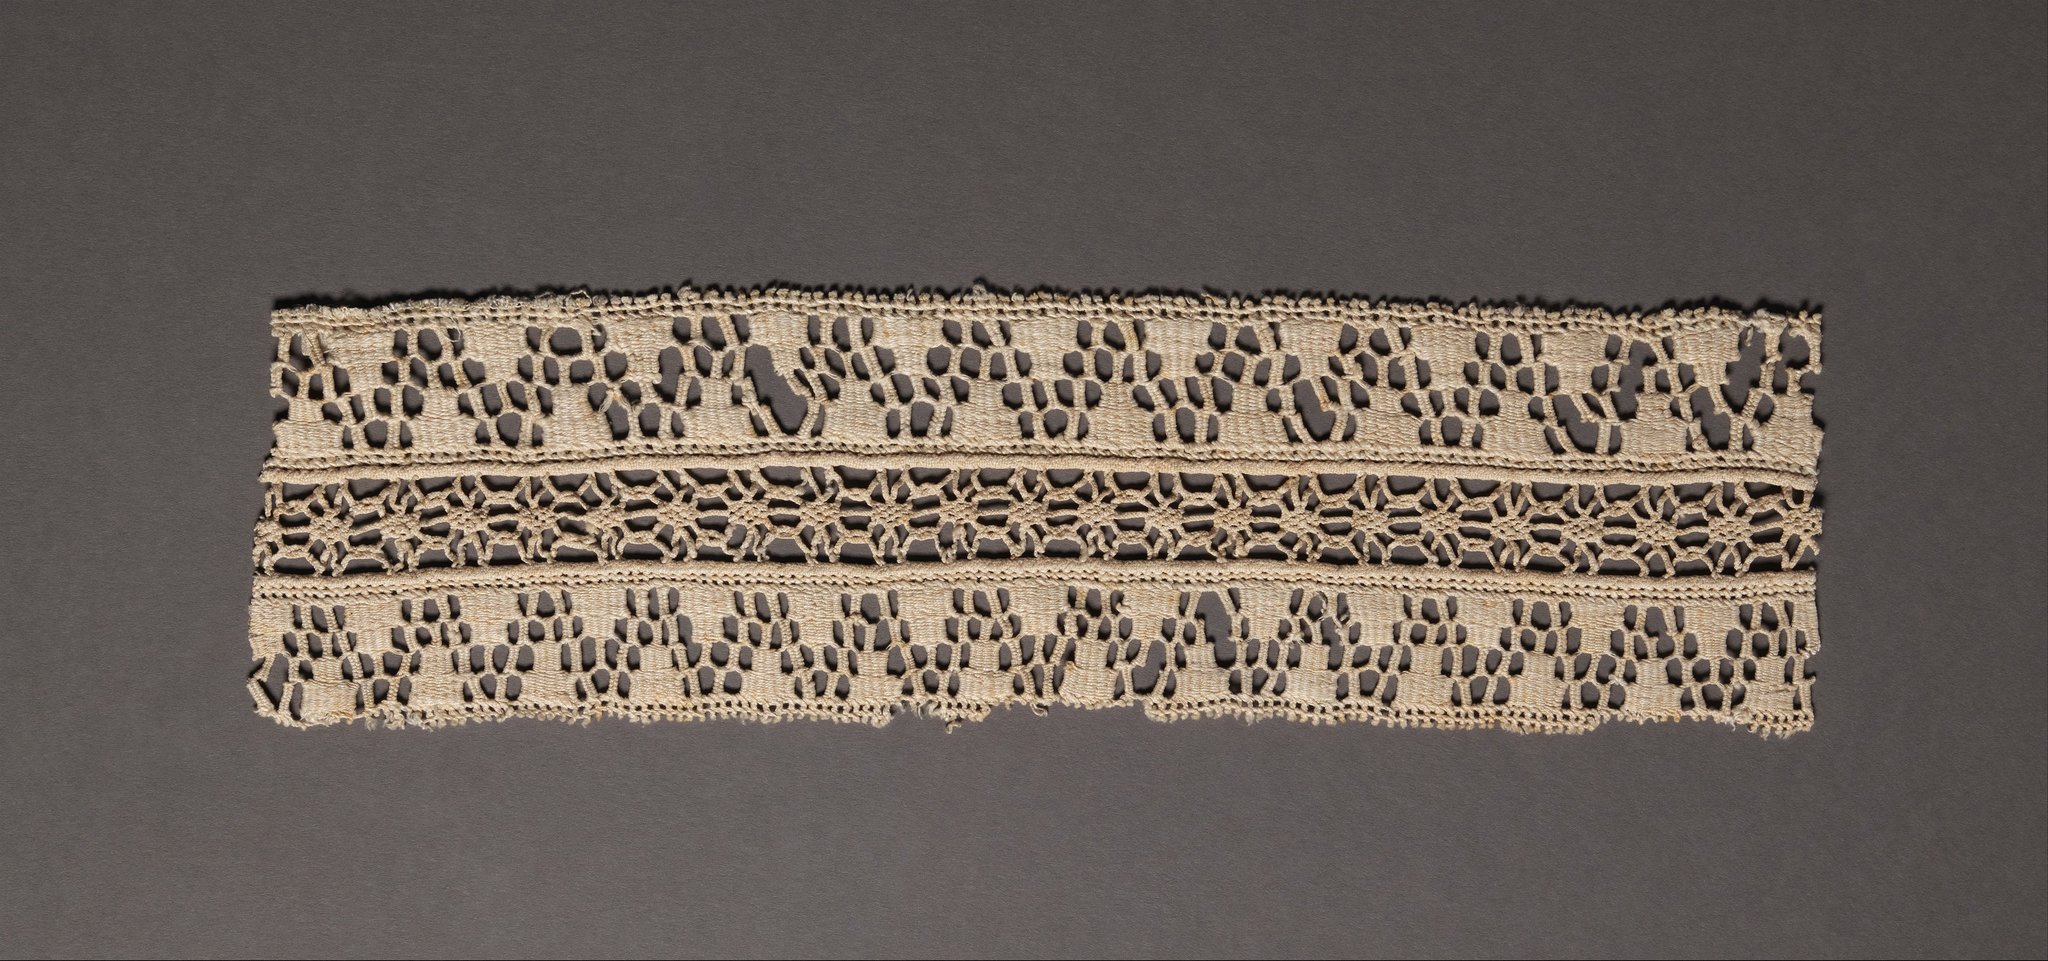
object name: strip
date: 1501-1600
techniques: lace, embroidery